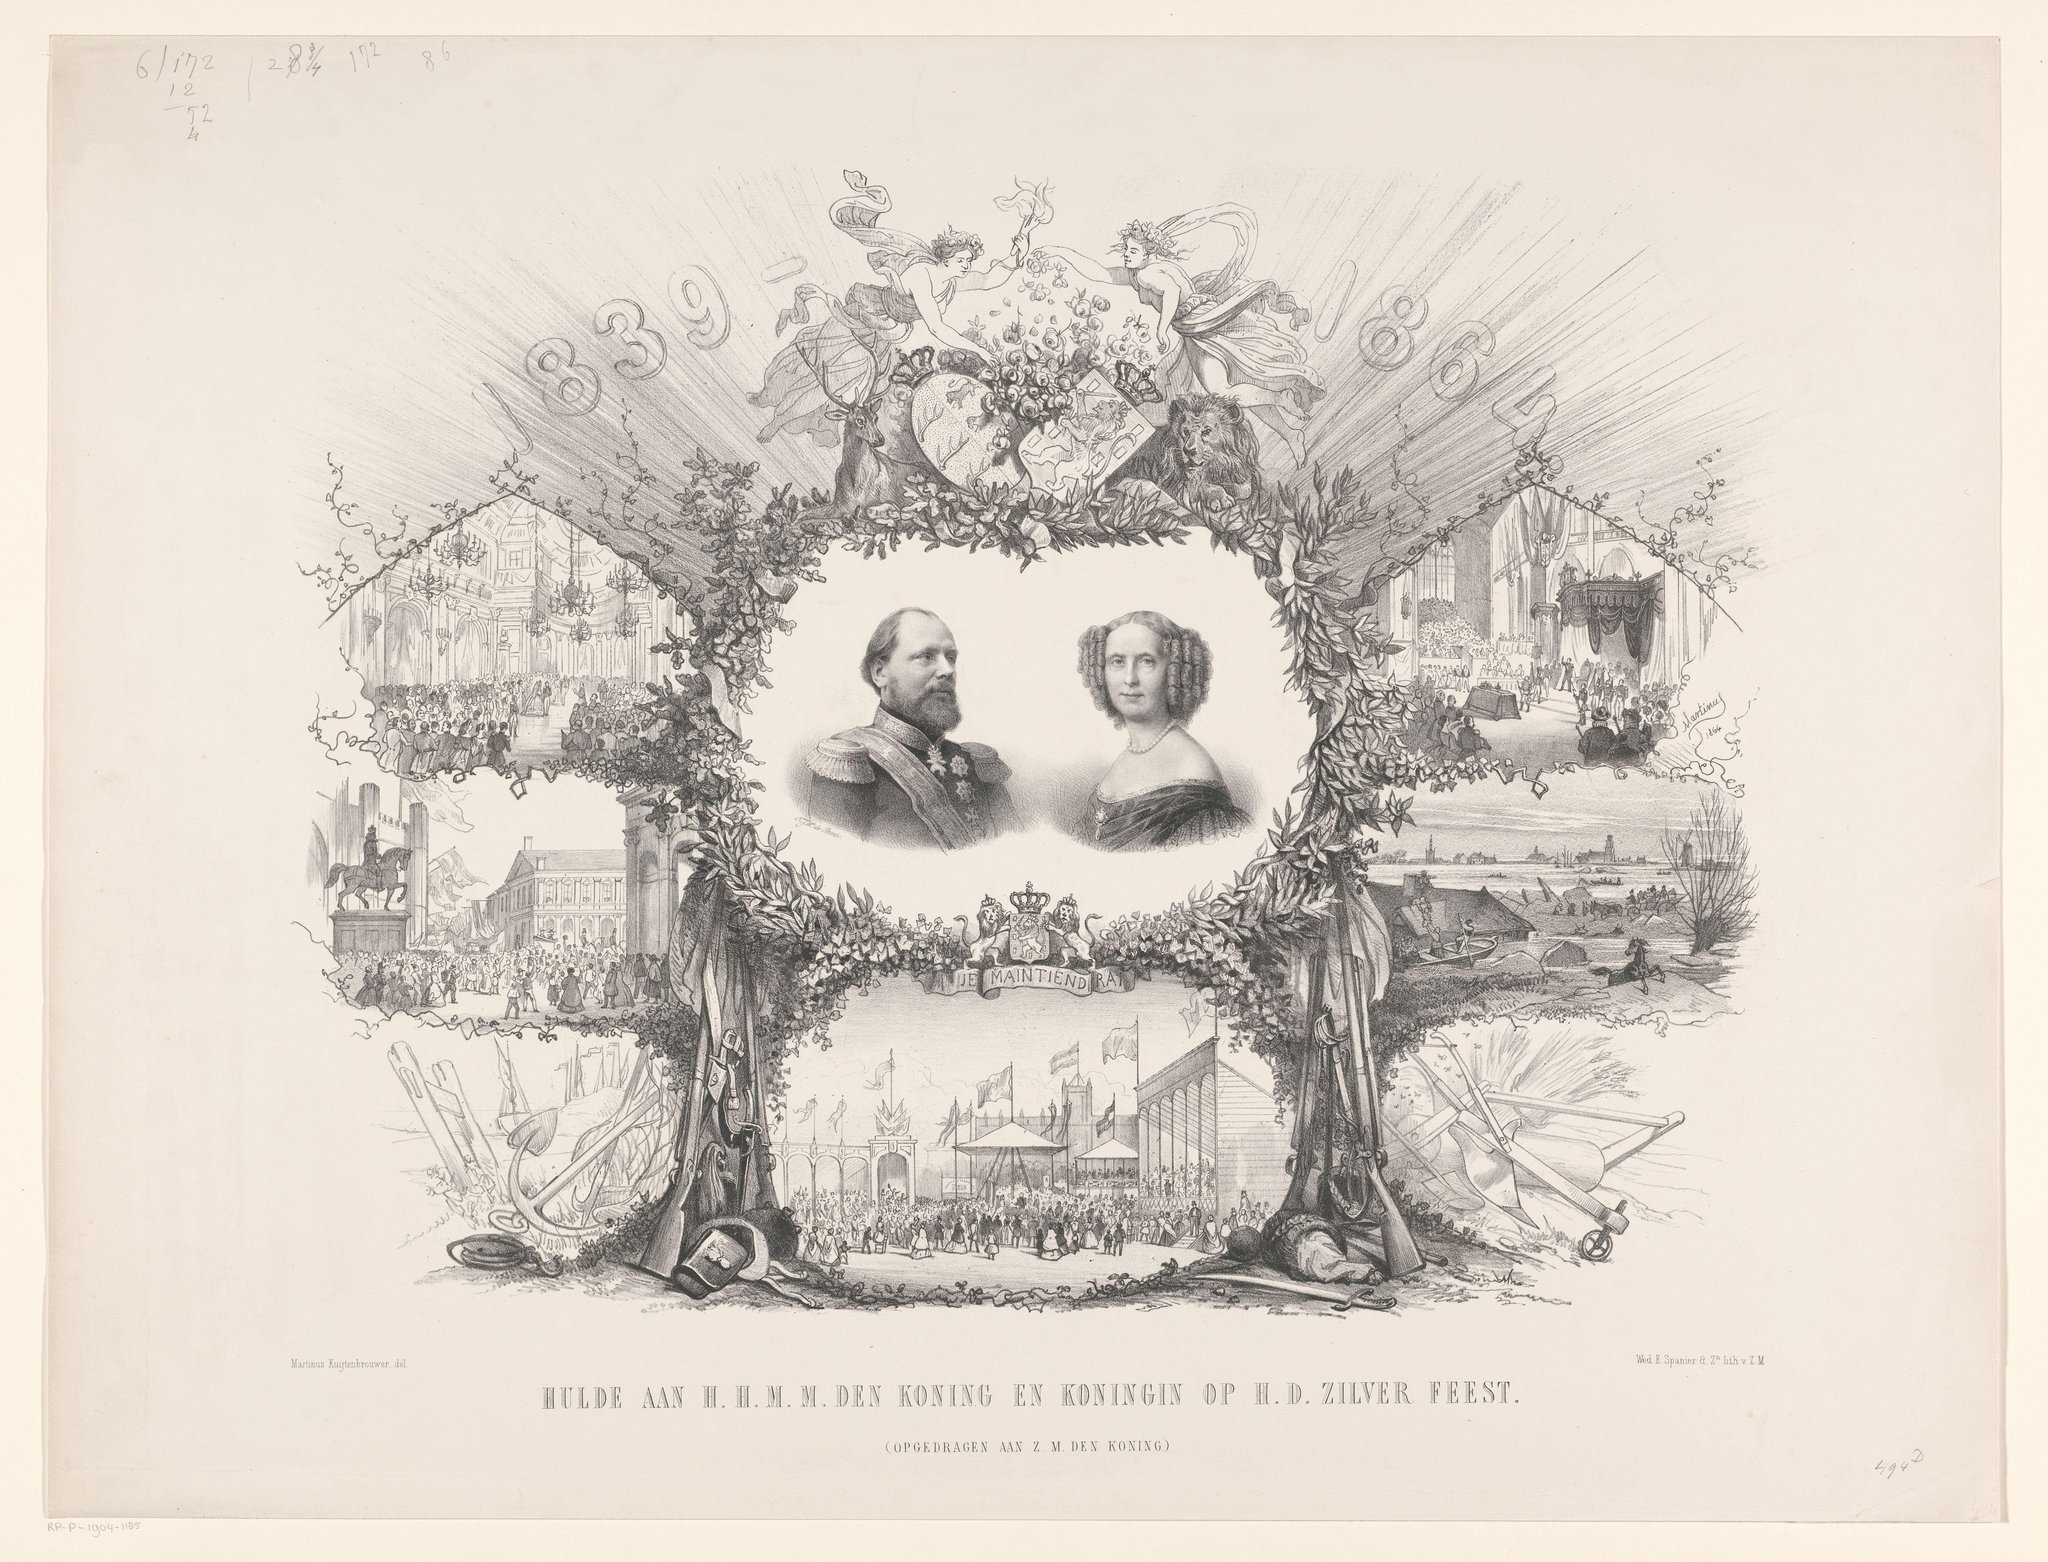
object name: print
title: Hulde aan H.H.M.M. den Koning en Koningin op H.D. Zilver Feest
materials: paper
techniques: lithograph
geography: the hague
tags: brussels, willem iii (koning der nederlanden), the hague, sophia frederika mathilda van württemberg, silver anniversary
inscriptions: collector's mark: Lugt 2228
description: Gedenkblad ter gelegenheid van het zilveren huwelijk van koning Willem I en koningin Sophie van Württemberg, op 18 juni 1864. Centraal de portretten van het paar. Hieromheen voorstellingen van het huwelijk van de prins in 1839, de inhuldiging van de koning in 1849, de watersnood van 1861, het leggen van de eerste steen voor het Nationaal Monument in 1863 en de vestiging van het paar in Den Haag.